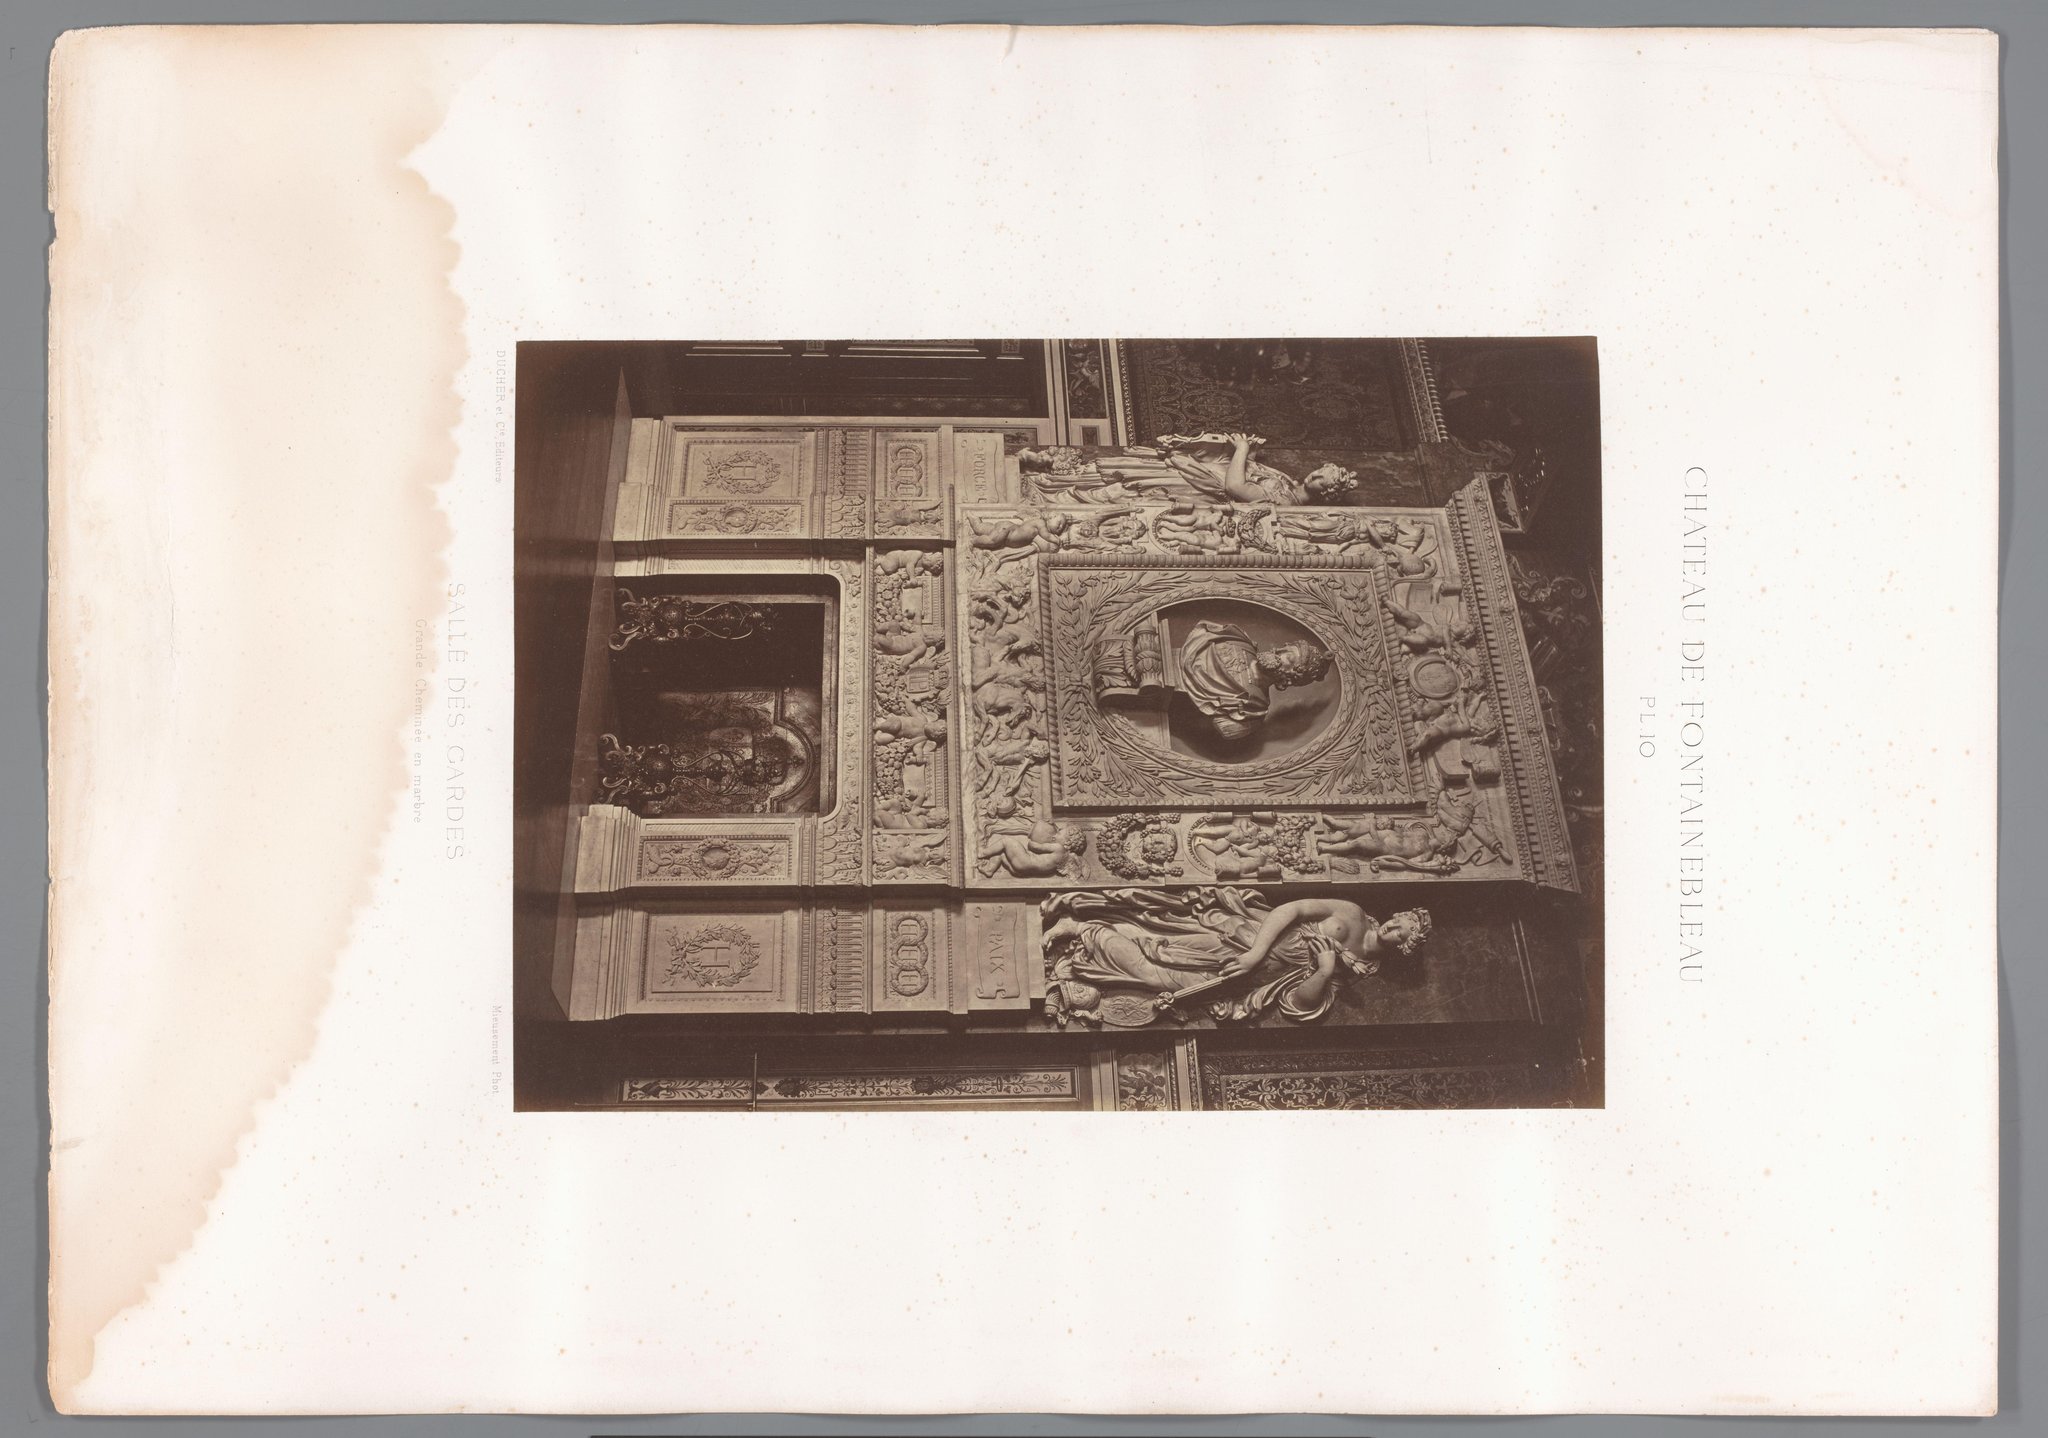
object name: photograph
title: Gezicht op een marmeren haard in de Salle des Gardes van het Kasteel van Fontainebleau, Frankrijk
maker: séraphin-médéric mieusement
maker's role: fotograaf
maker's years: 1840-1905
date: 1870-1875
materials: photographic support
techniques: albumen print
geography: fontainebleau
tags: castle - aa - civic architecture: inside, chimney-piece, mantelpiece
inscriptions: number: ‘PL. 10.’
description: Deze foto maakt deel uit van een omslag met dertig foto's en twee tekstbladen.